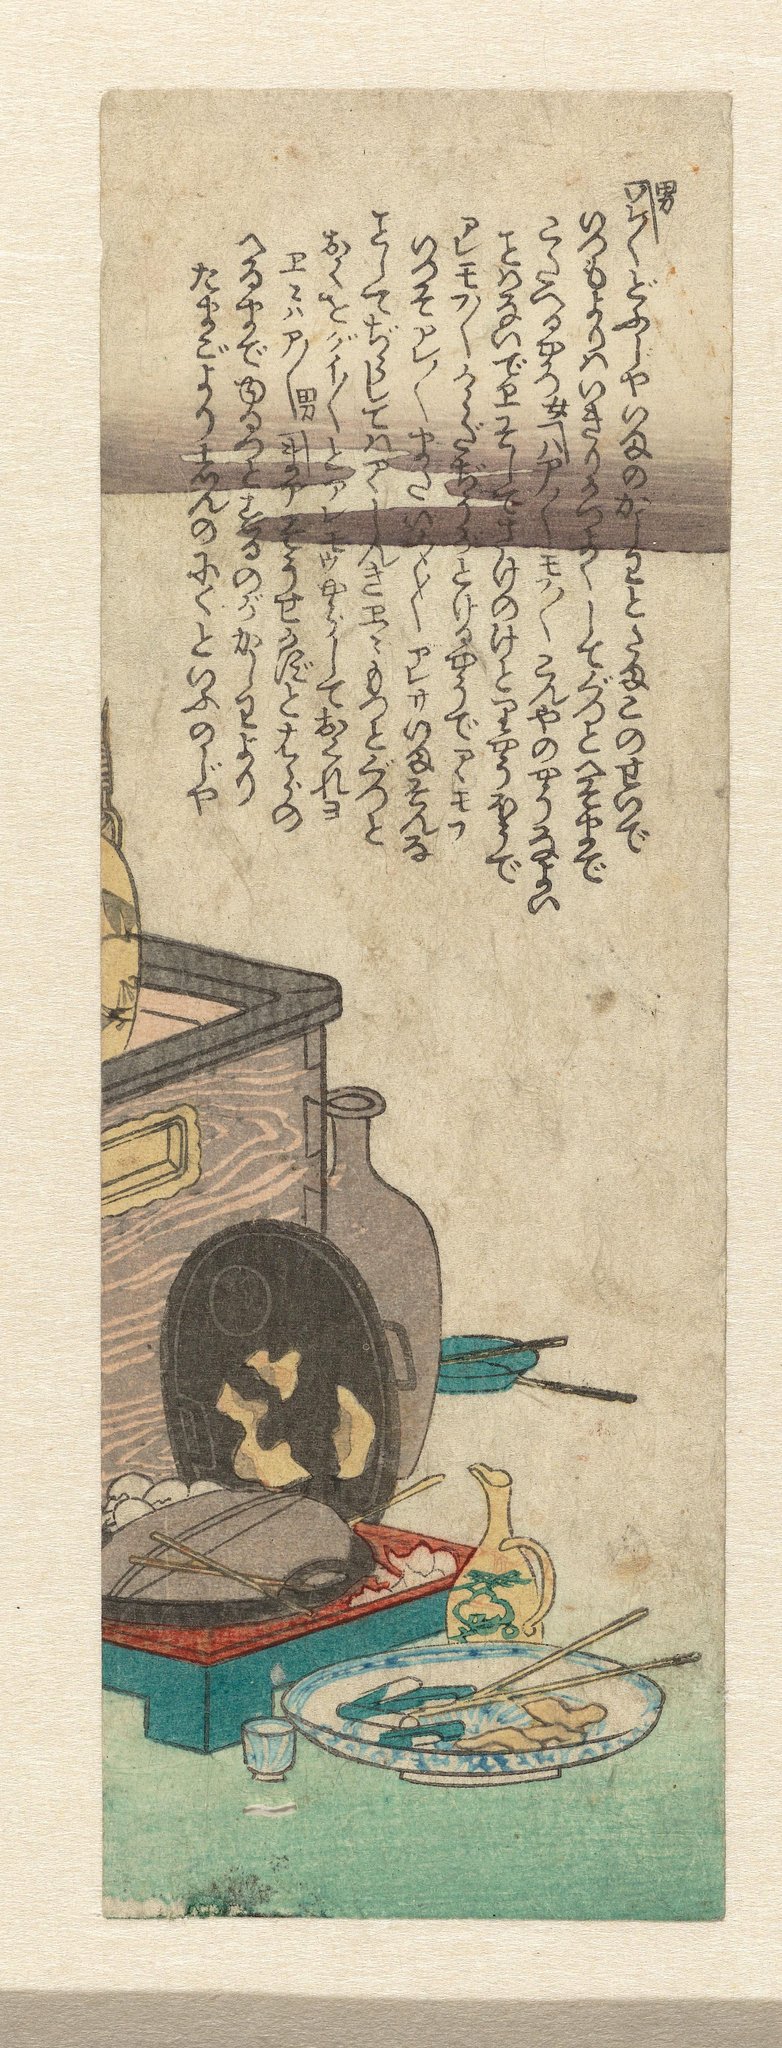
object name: print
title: Achtdelige serie met shunga-prenten (iro yôkan; zenbu hitosao)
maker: Anonymous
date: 1850-1860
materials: paper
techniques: woodcut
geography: japan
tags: table-ware